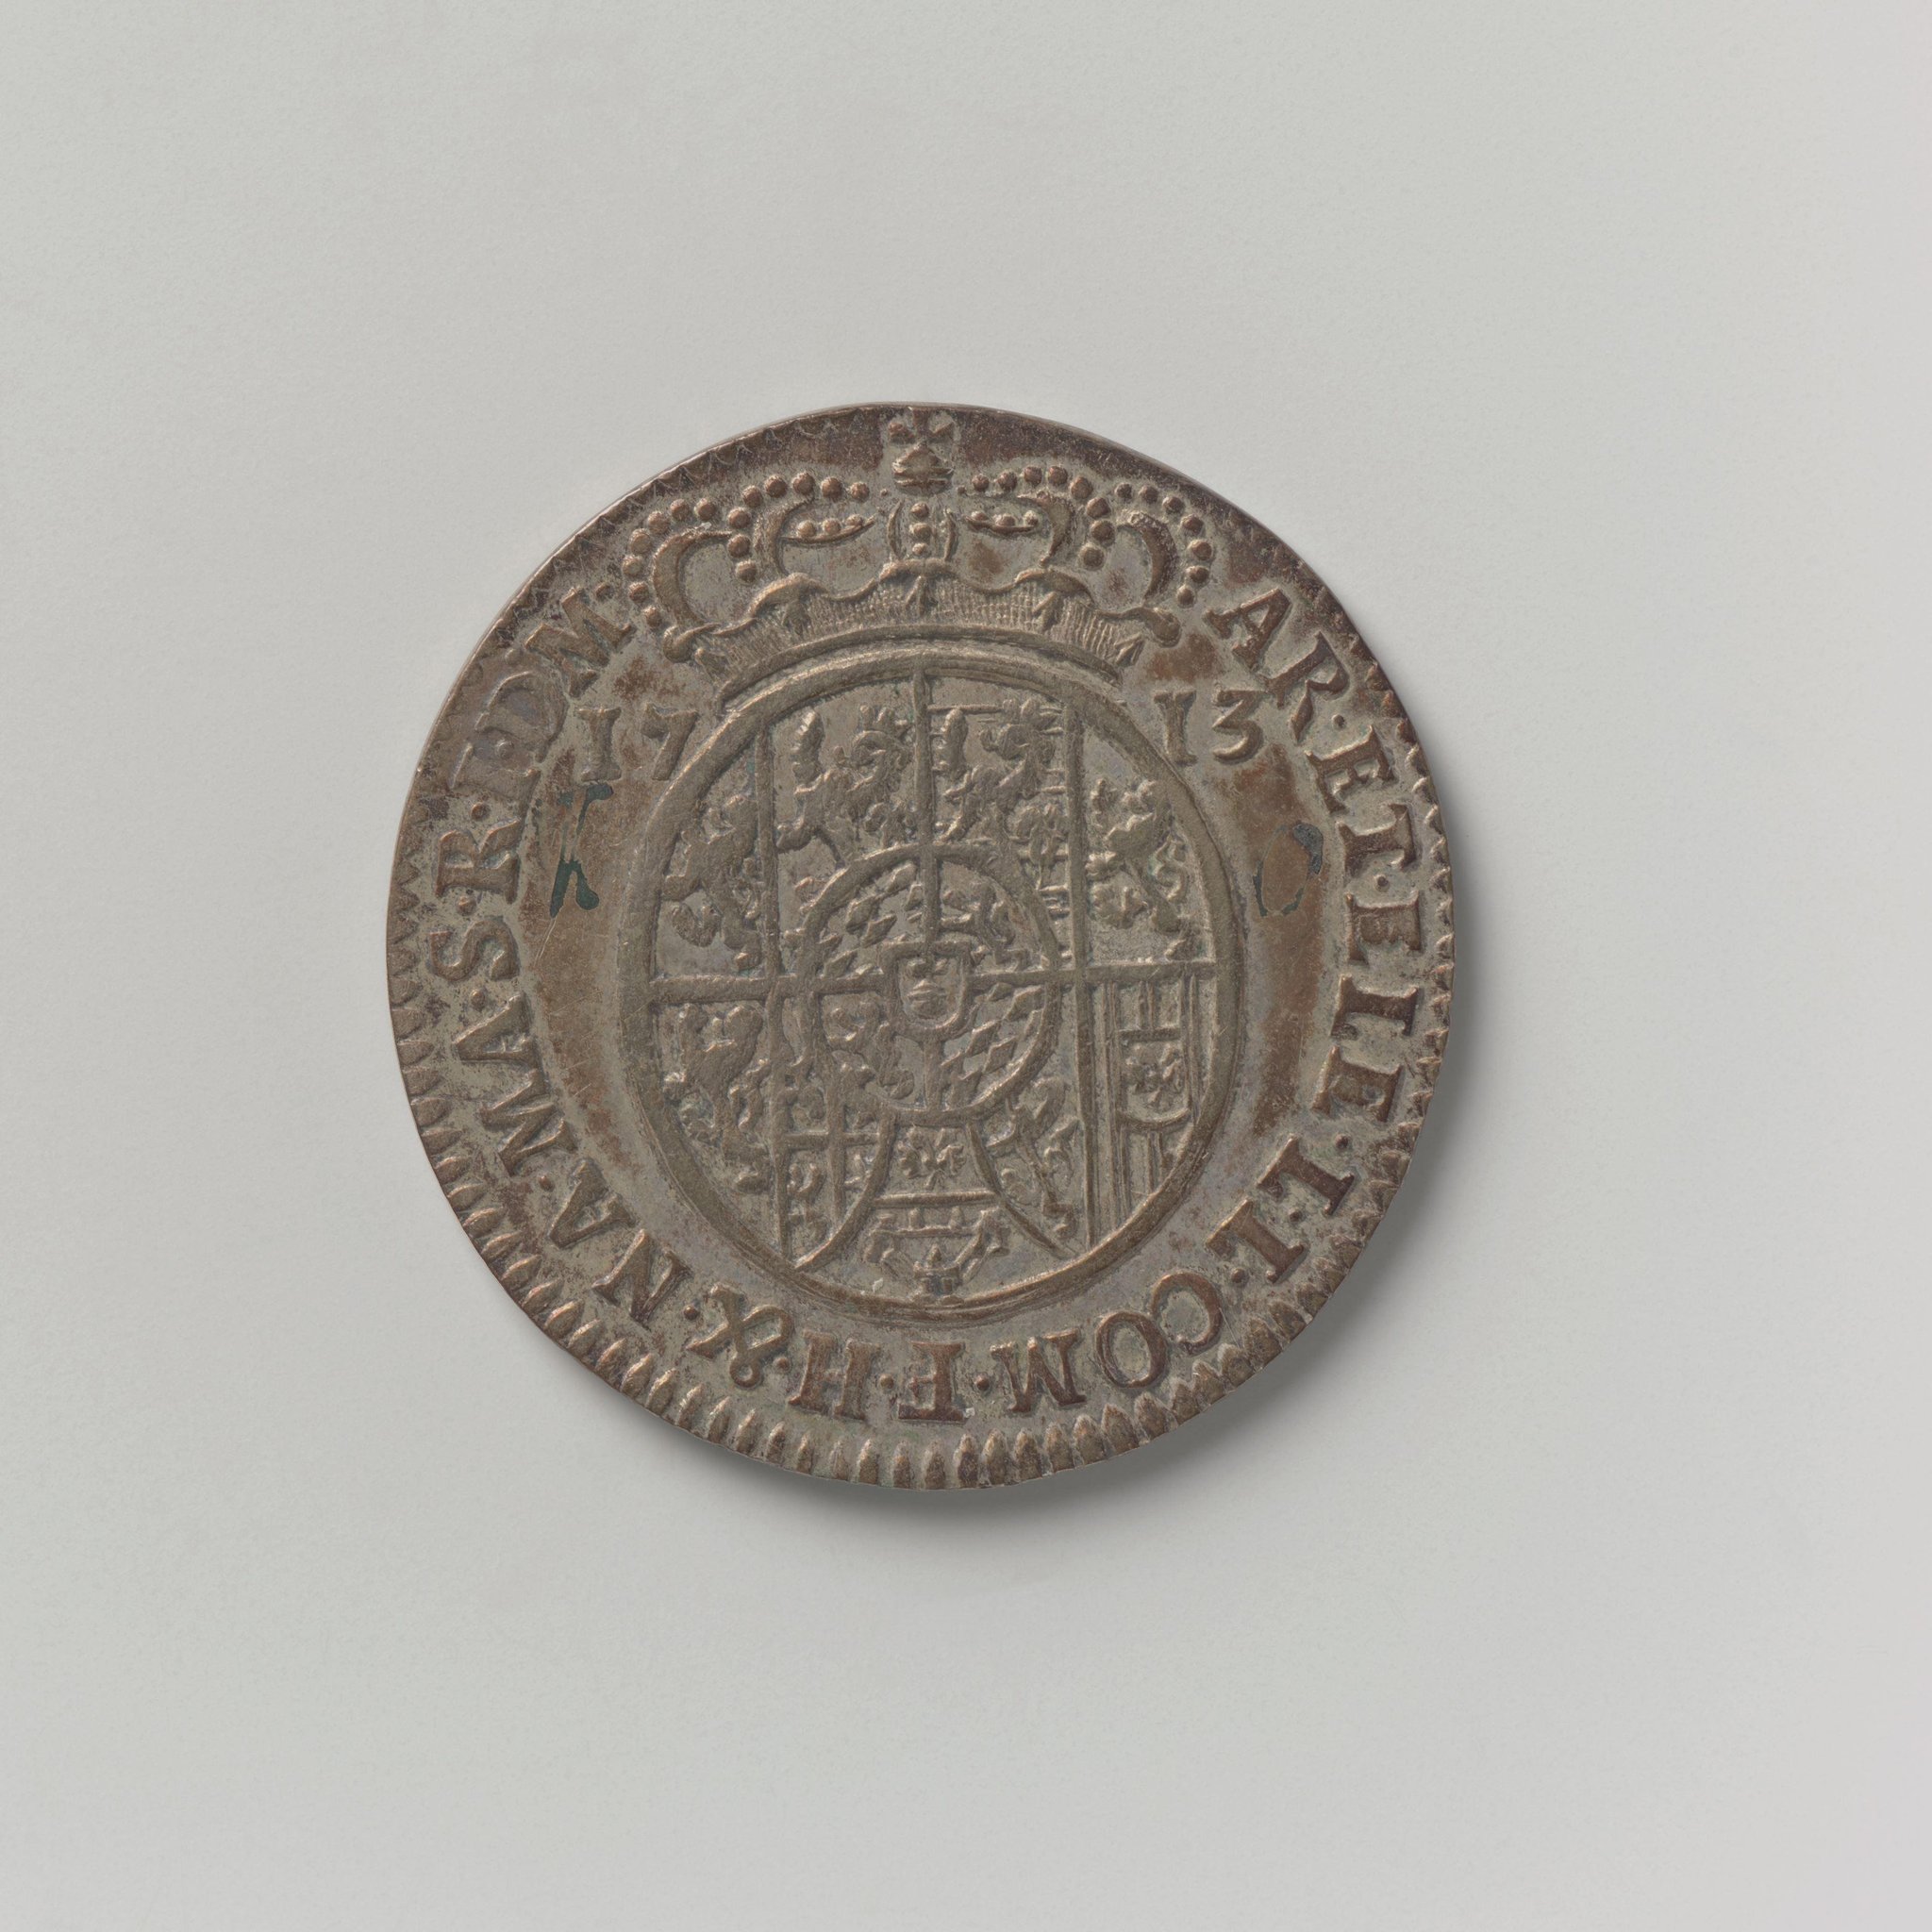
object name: coin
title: Namen, Maximiliaan-Emanuel, 1713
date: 1713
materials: silver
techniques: striking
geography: namur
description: Zilveren munt. Voorzijde: tussen jaartal gekroond wapenschild. Keerzijde: klimmende leeuw naar links, in rechterklauw zwaard, linker klauw rustend op wapenschild. Gladde rand.